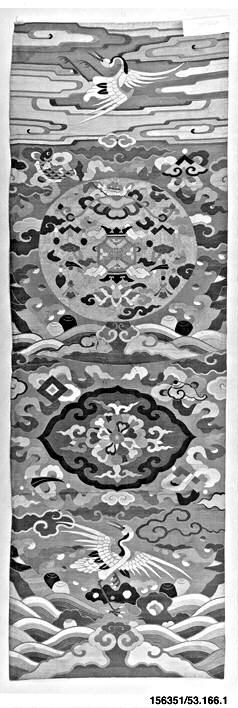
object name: chair strip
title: Chair Strip with Cranes and Lantern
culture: chinese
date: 1601-1700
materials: metal thread, silk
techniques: tapestry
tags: cranes